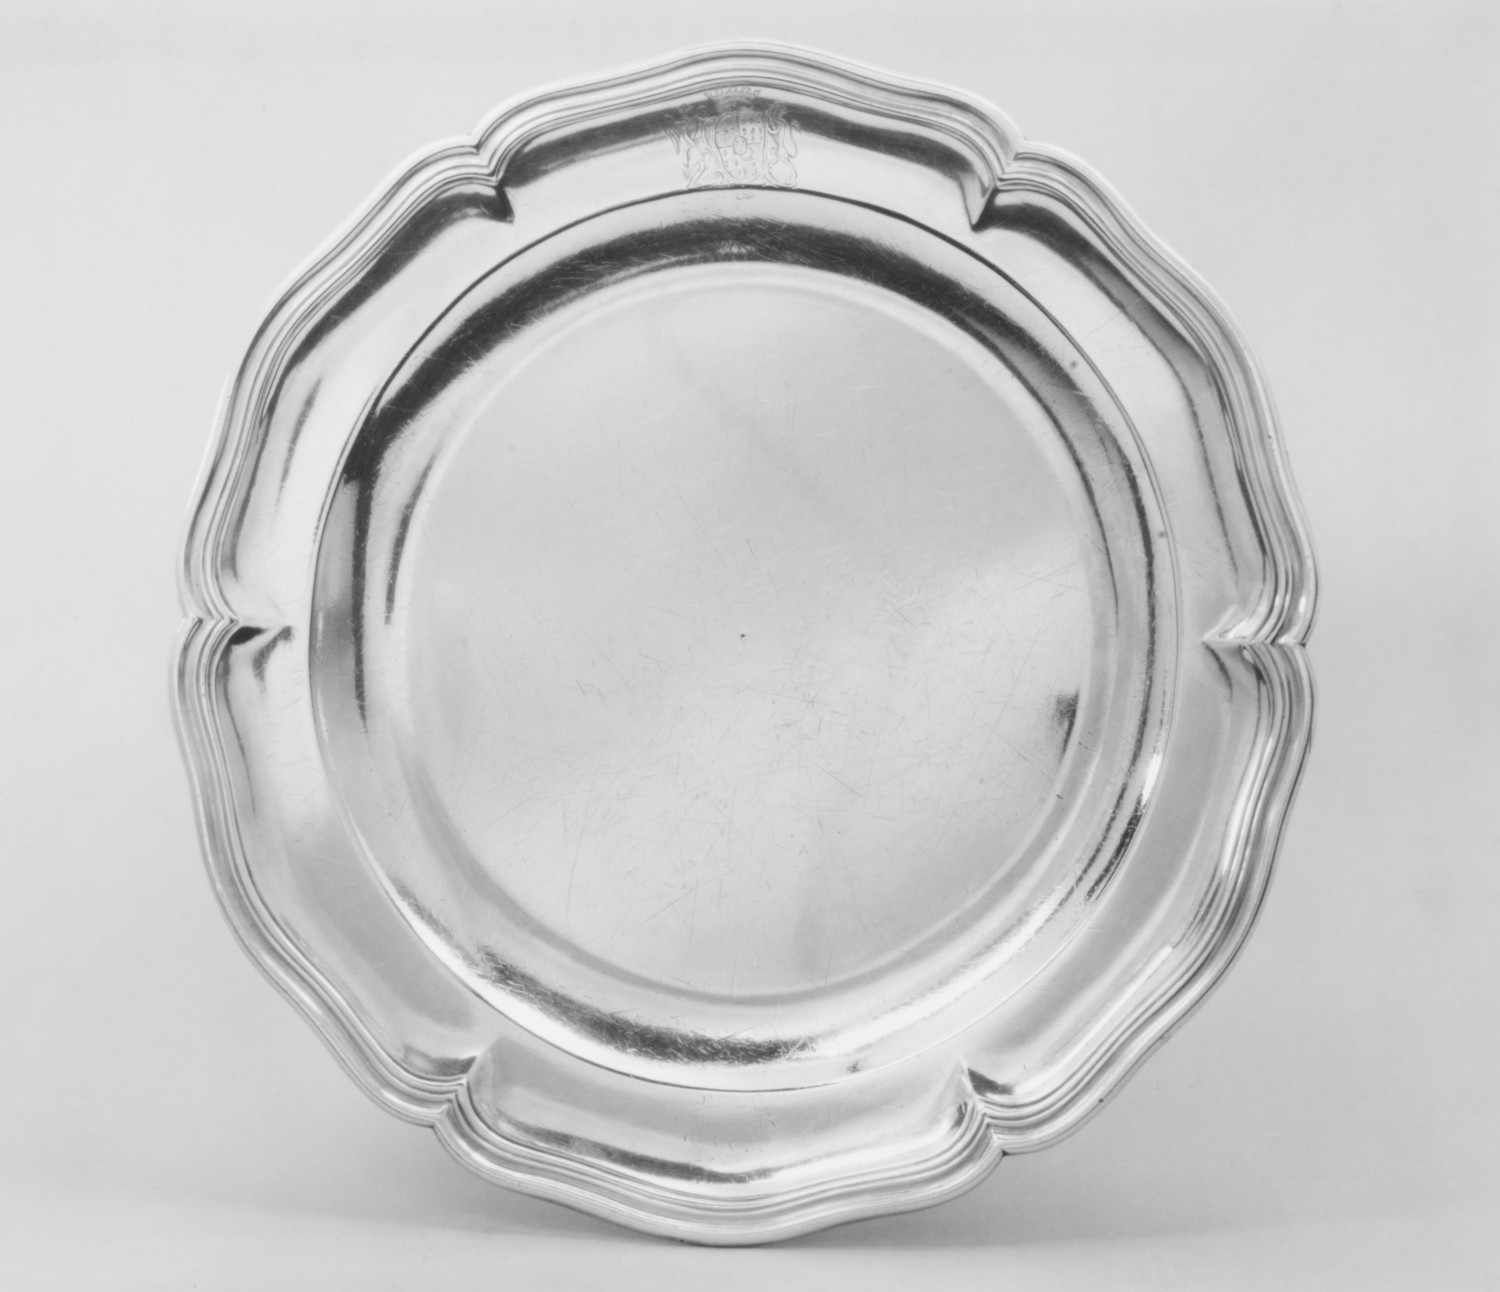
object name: plate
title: Plate with the arms of marquis Gaspard de Gueidan (1688–1767)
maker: honoré burel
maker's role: maker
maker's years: 1718-1778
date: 1759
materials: silver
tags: coat of arms